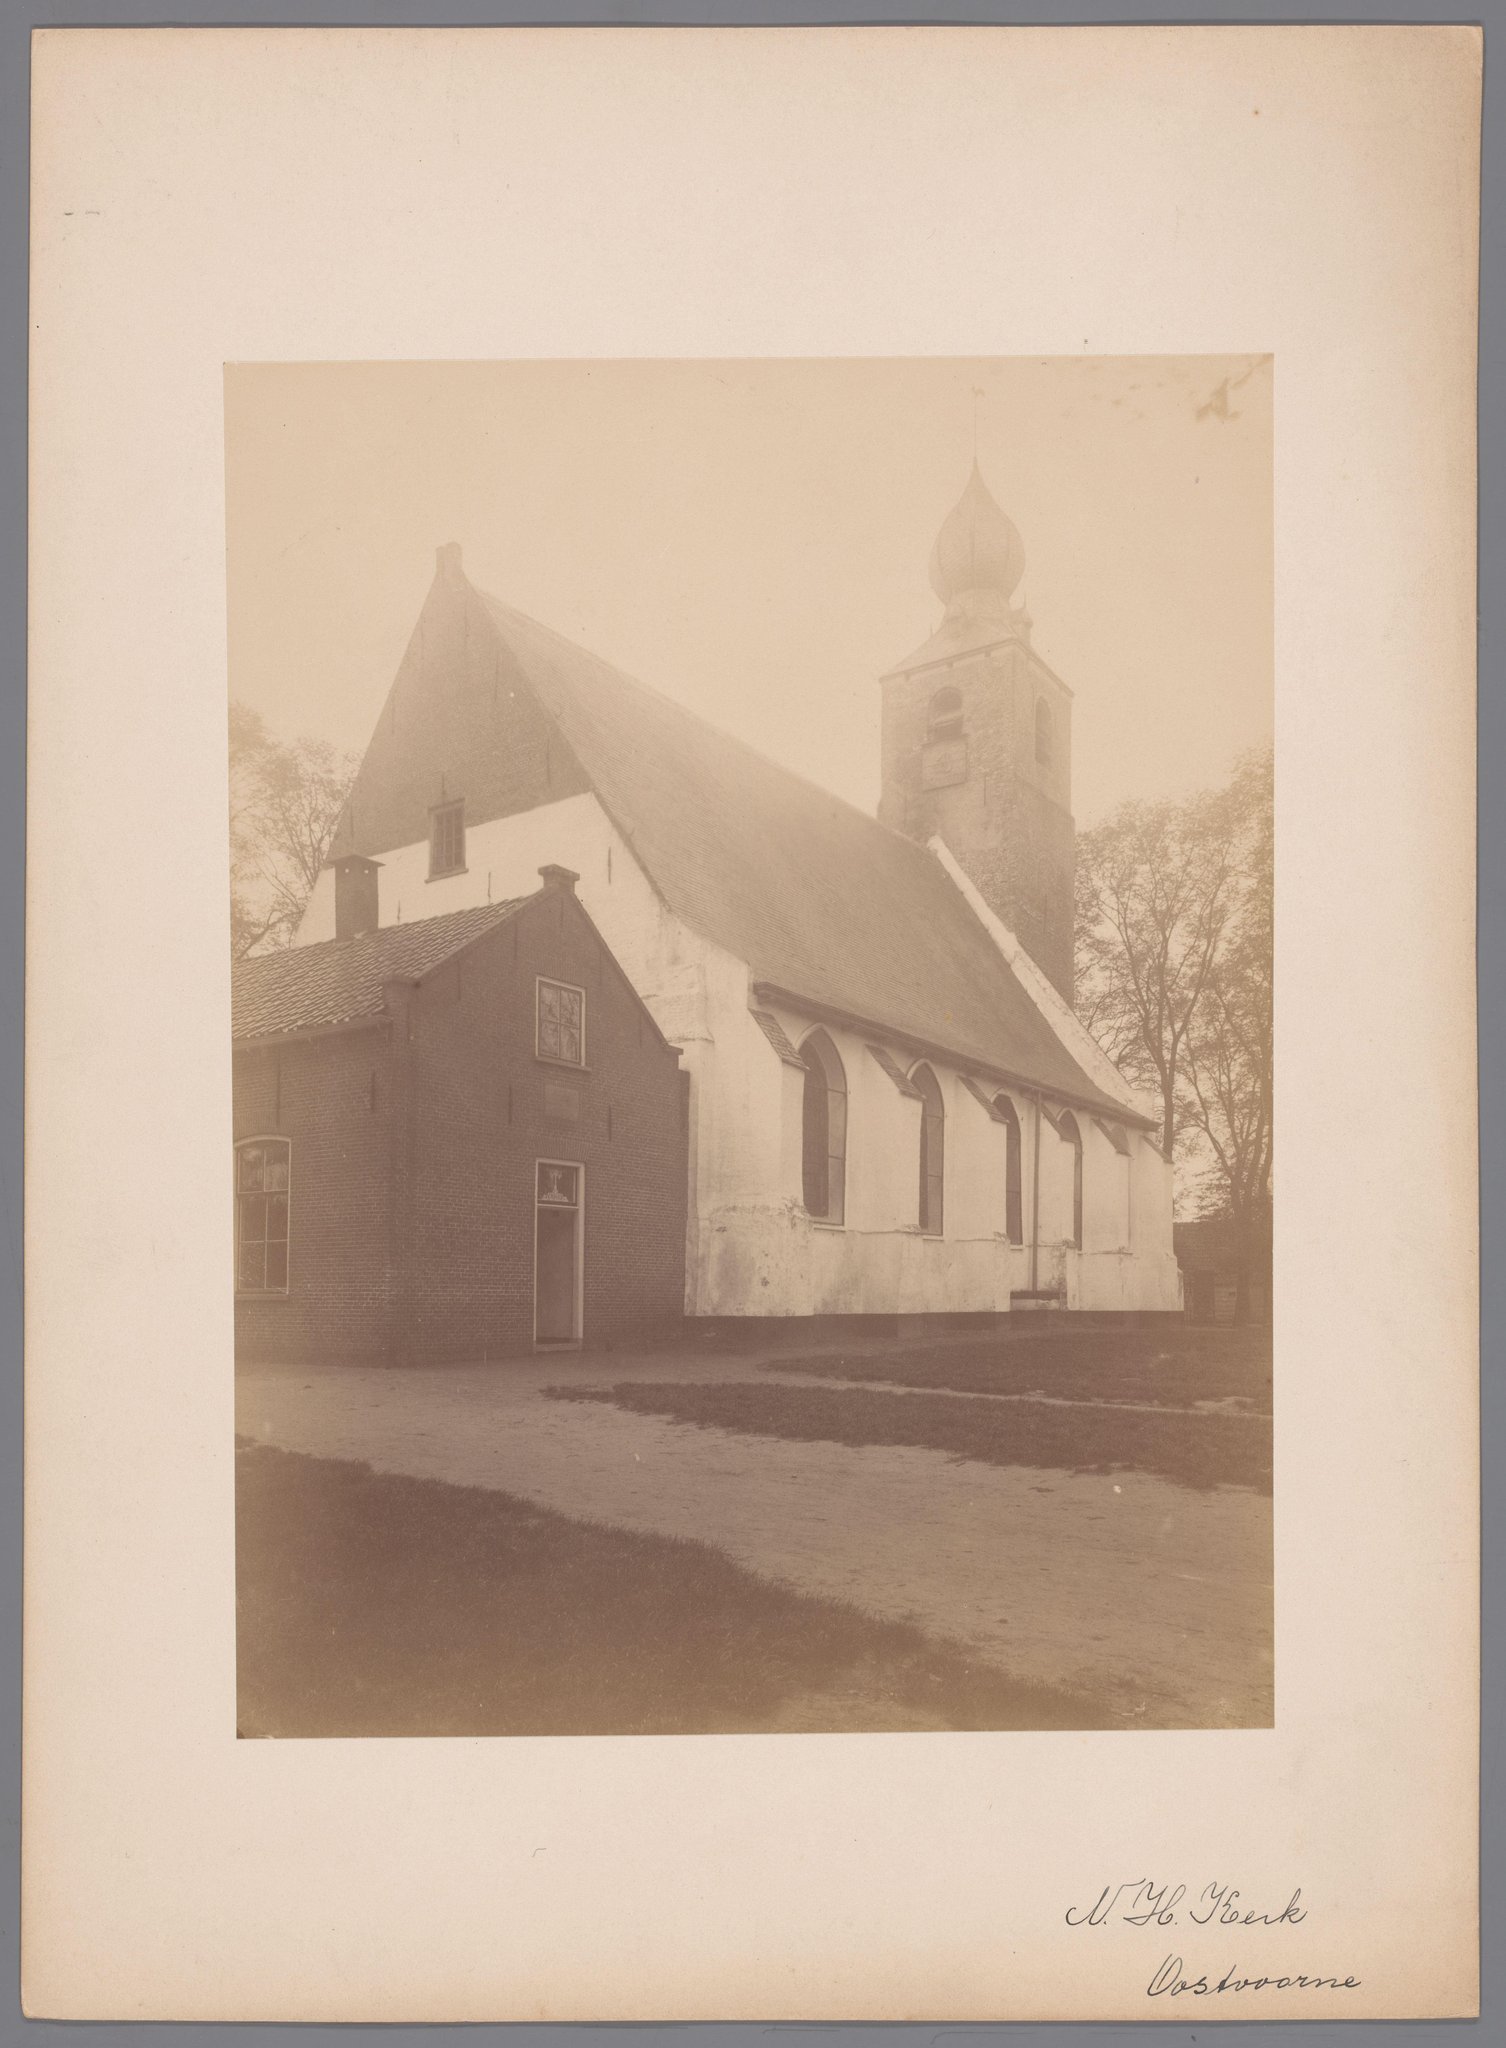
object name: photograph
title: Gezicht op de Dorpskerk te Oostvoorne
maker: anoniem (monumentenzorg)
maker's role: fotograaf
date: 1890-1920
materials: cardboard, photographic support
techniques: albumen print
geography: oostvoorne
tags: church (exterior), oostvoorne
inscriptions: annotation: ‘Oostvoorne/ Ned. Herv. Kerk’, annotation: ‘N.H. Kerk/ Oostvoorne’